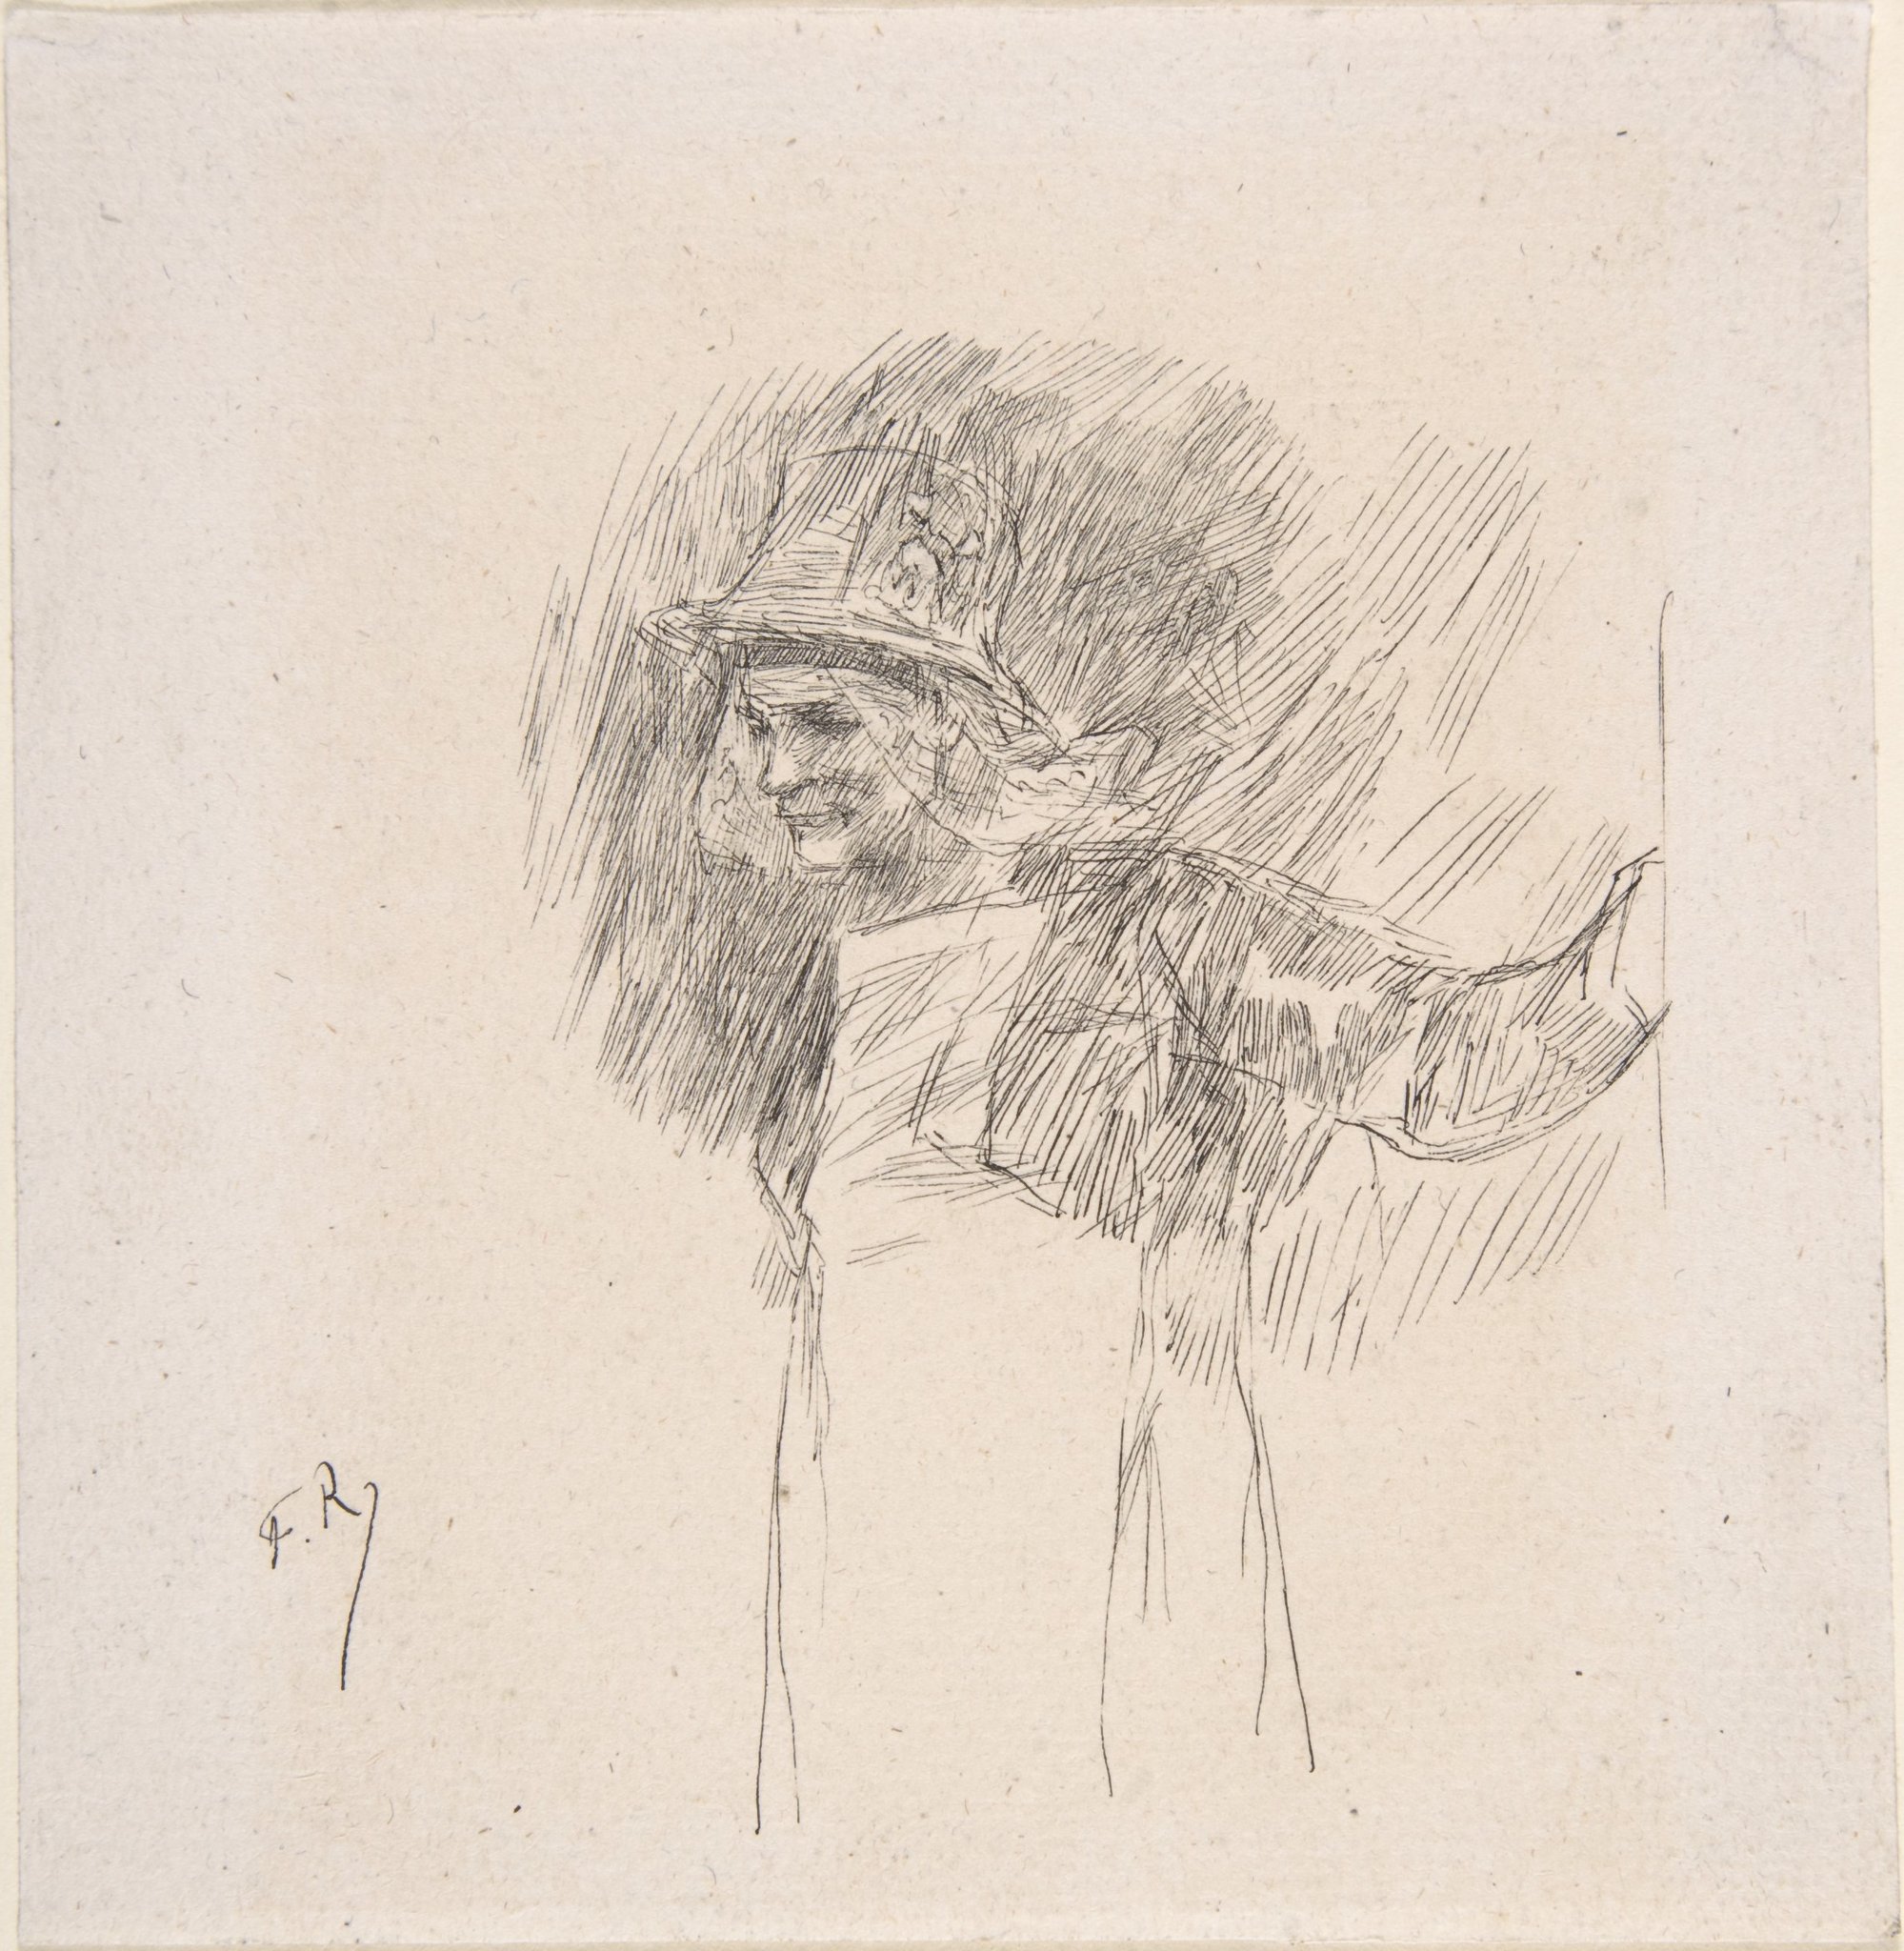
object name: drawing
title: The Old Flemish Woman (La Vieille Flamande)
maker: félicien rops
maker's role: artist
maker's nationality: belgian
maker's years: 1833-1898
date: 1833-1898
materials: ink, paper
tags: women